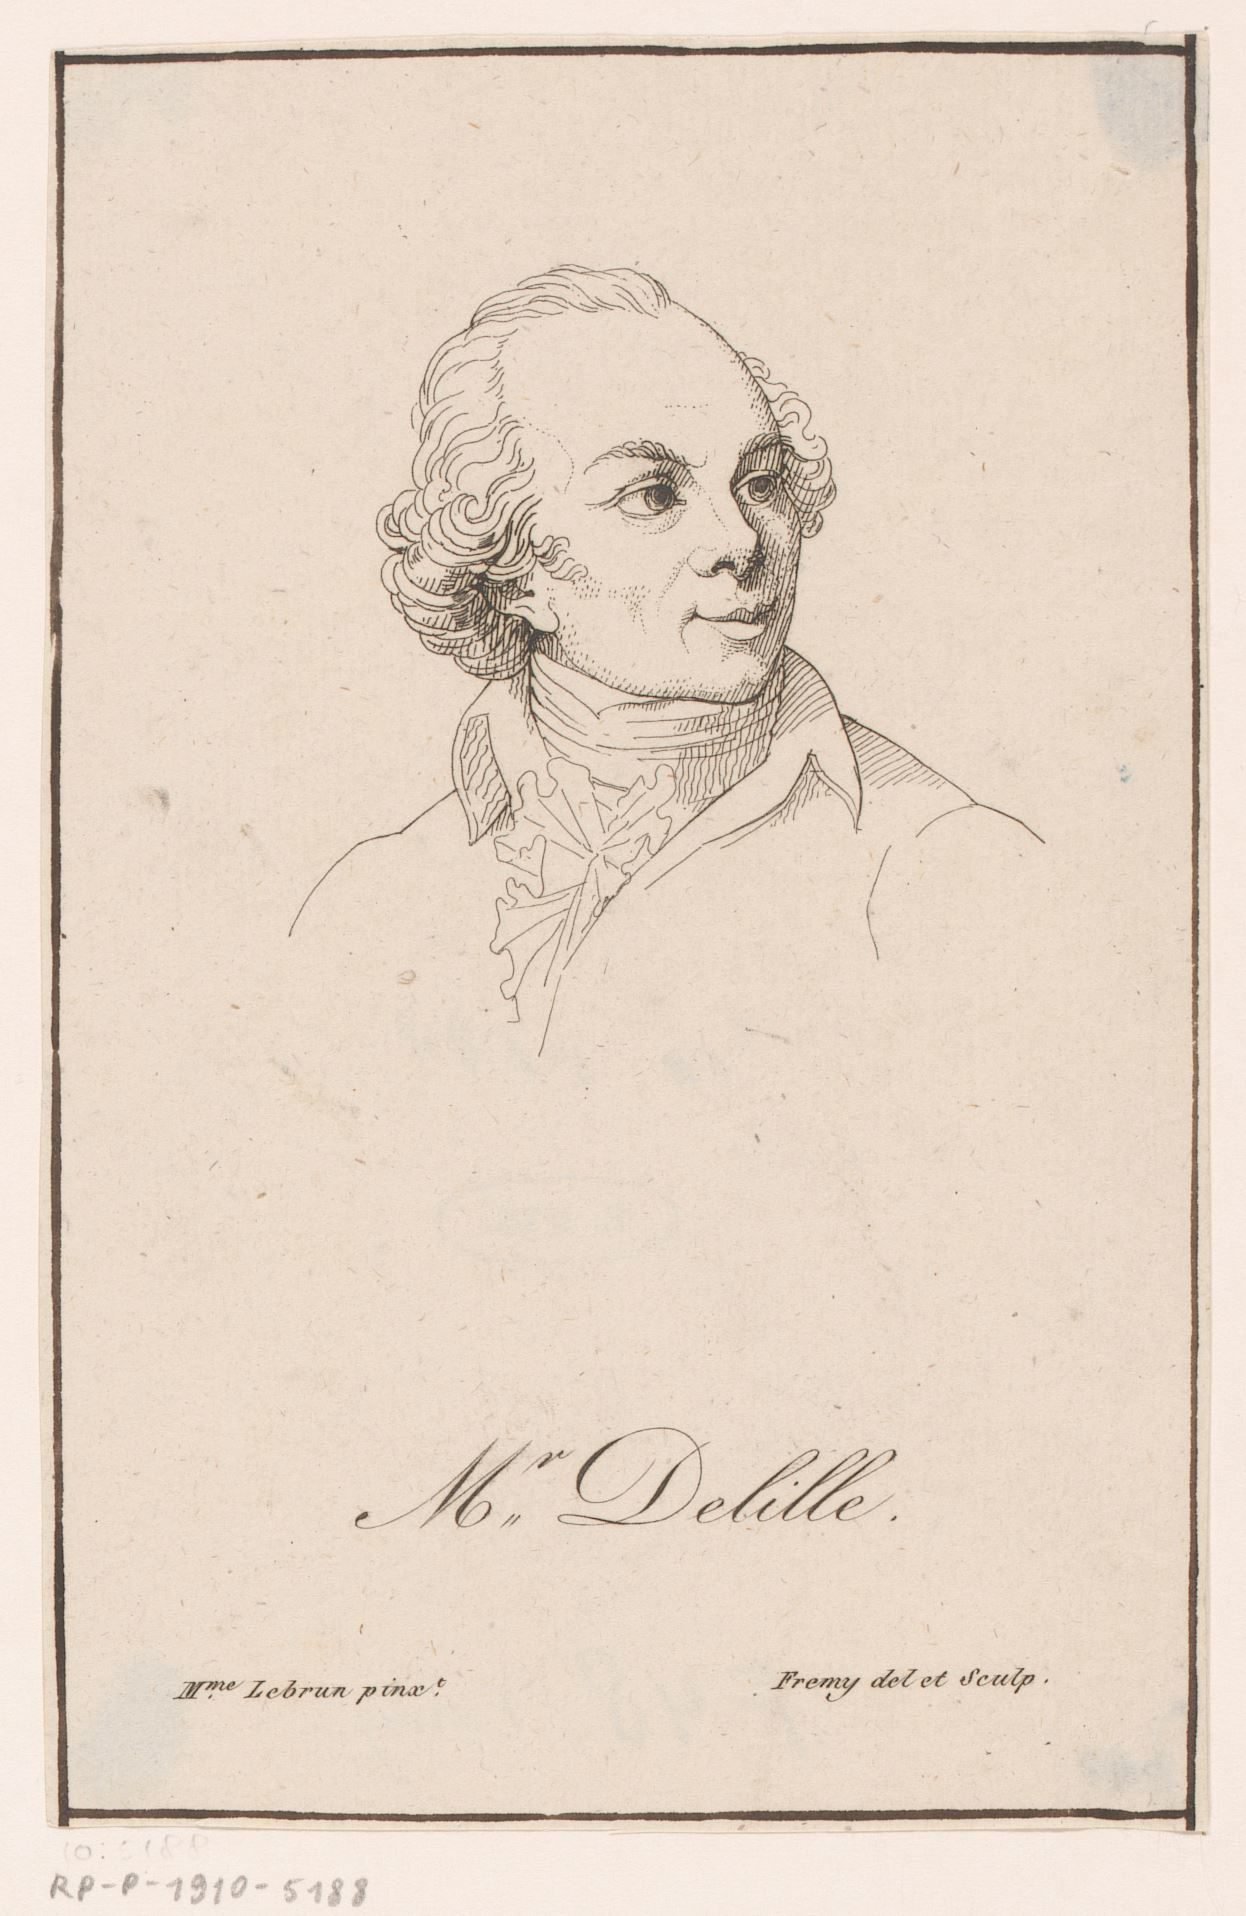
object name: print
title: Portret van Jacques Delille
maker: jacques noël marie frémy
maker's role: print maker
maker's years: 1782-1867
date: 1815-1817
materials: paper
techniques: etching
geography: france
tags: paris, jacques delille, historical persons, writer, poet, author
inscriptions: collector's mark: Lugt 2228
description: Mogelijk prent uit: Frémy, Jacques Noël Marie. Croquis de portraits des personnages remarquables dans tous les genres, dessinés et gravés. Parijs: Jacques Noël Marie Frémy, 1815-1817.